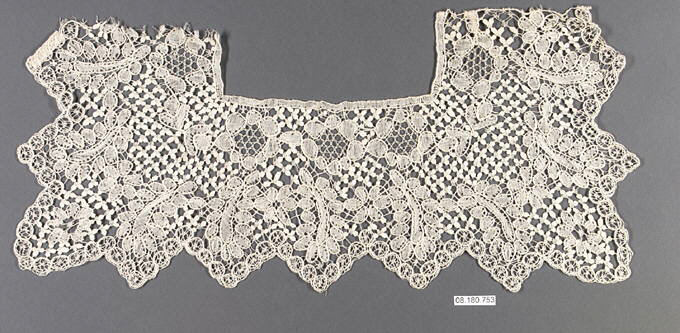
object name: handkerchief border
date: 1801-1900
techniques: lace